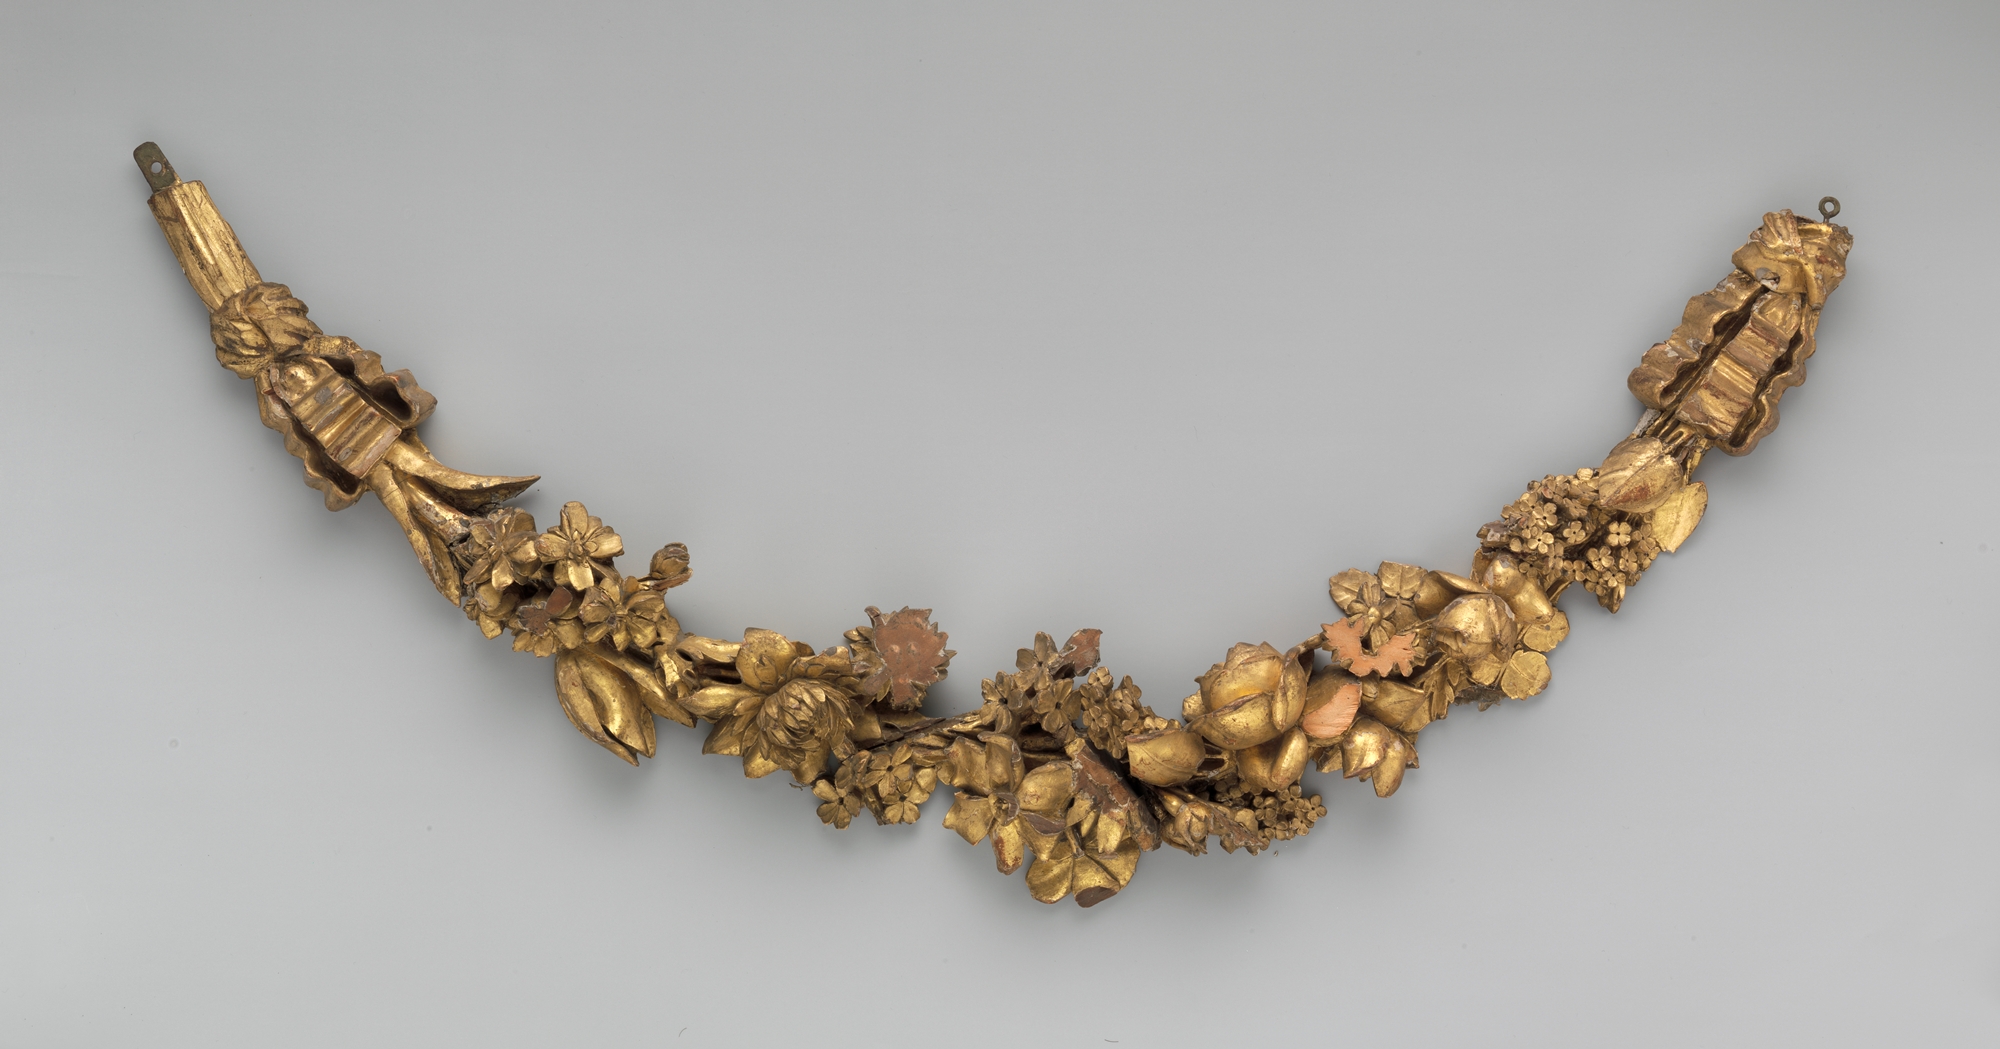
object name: garland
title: Garland (part of a set)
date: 1701-1800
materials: gilt, wood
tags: garlands,flowers